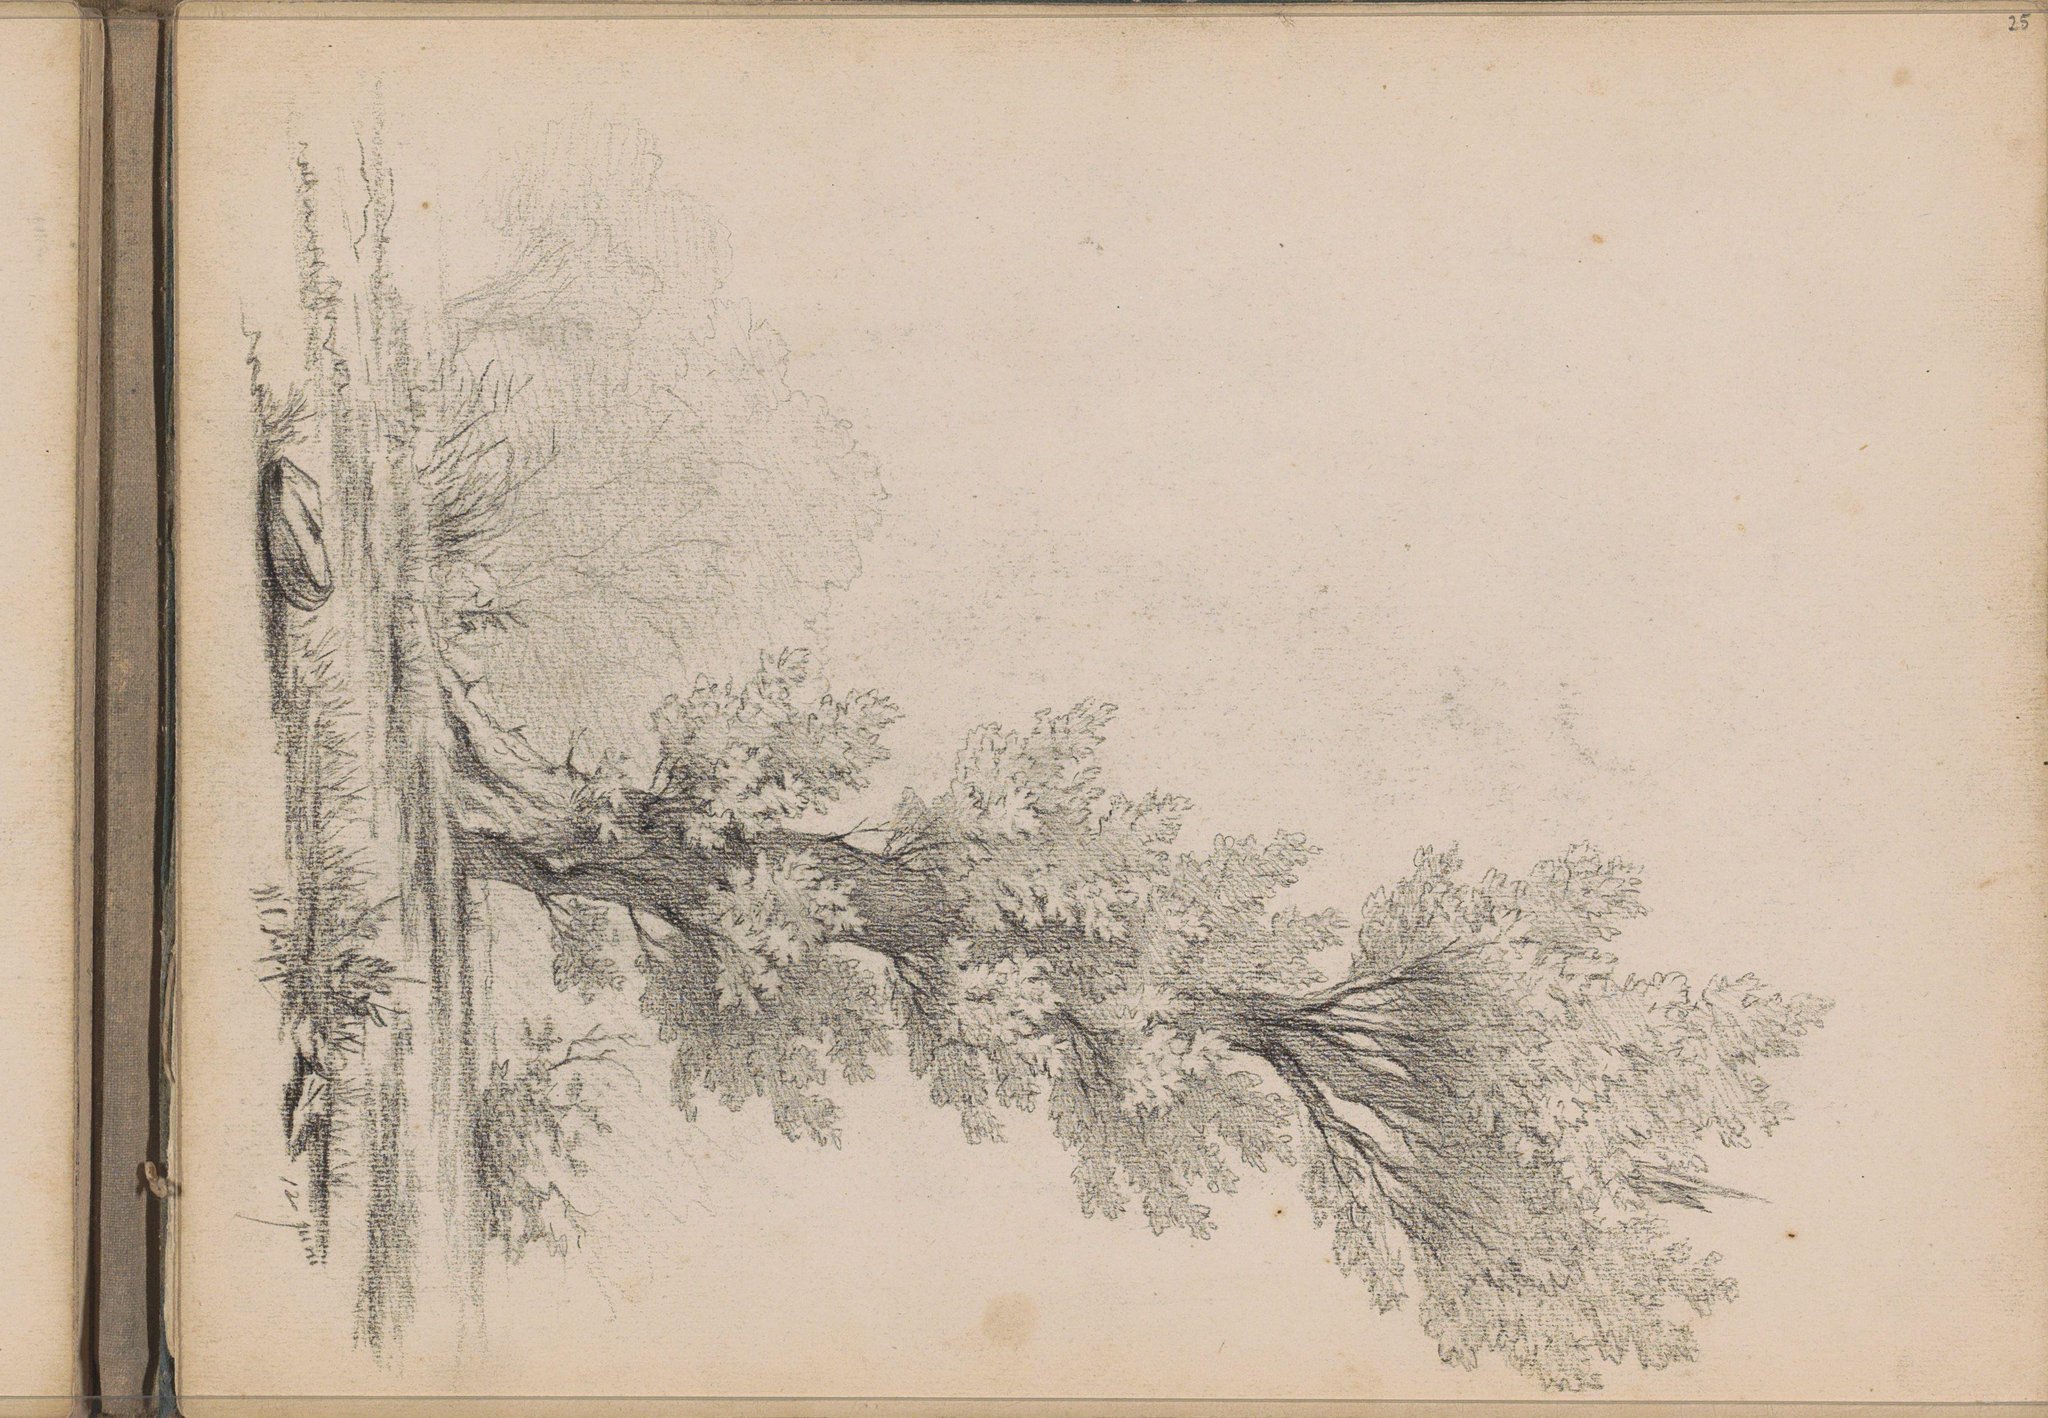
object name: sketchbook leaf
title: Landschap met boom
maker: willem cornelis rip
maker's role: draughtsman, painter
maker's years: 1856-1922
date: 1806-1874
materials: chalk, paper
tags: landscapes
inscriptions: date: ‘12 juni’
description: Blad 25 recto uit een schetsboek met 27 losse bladen.